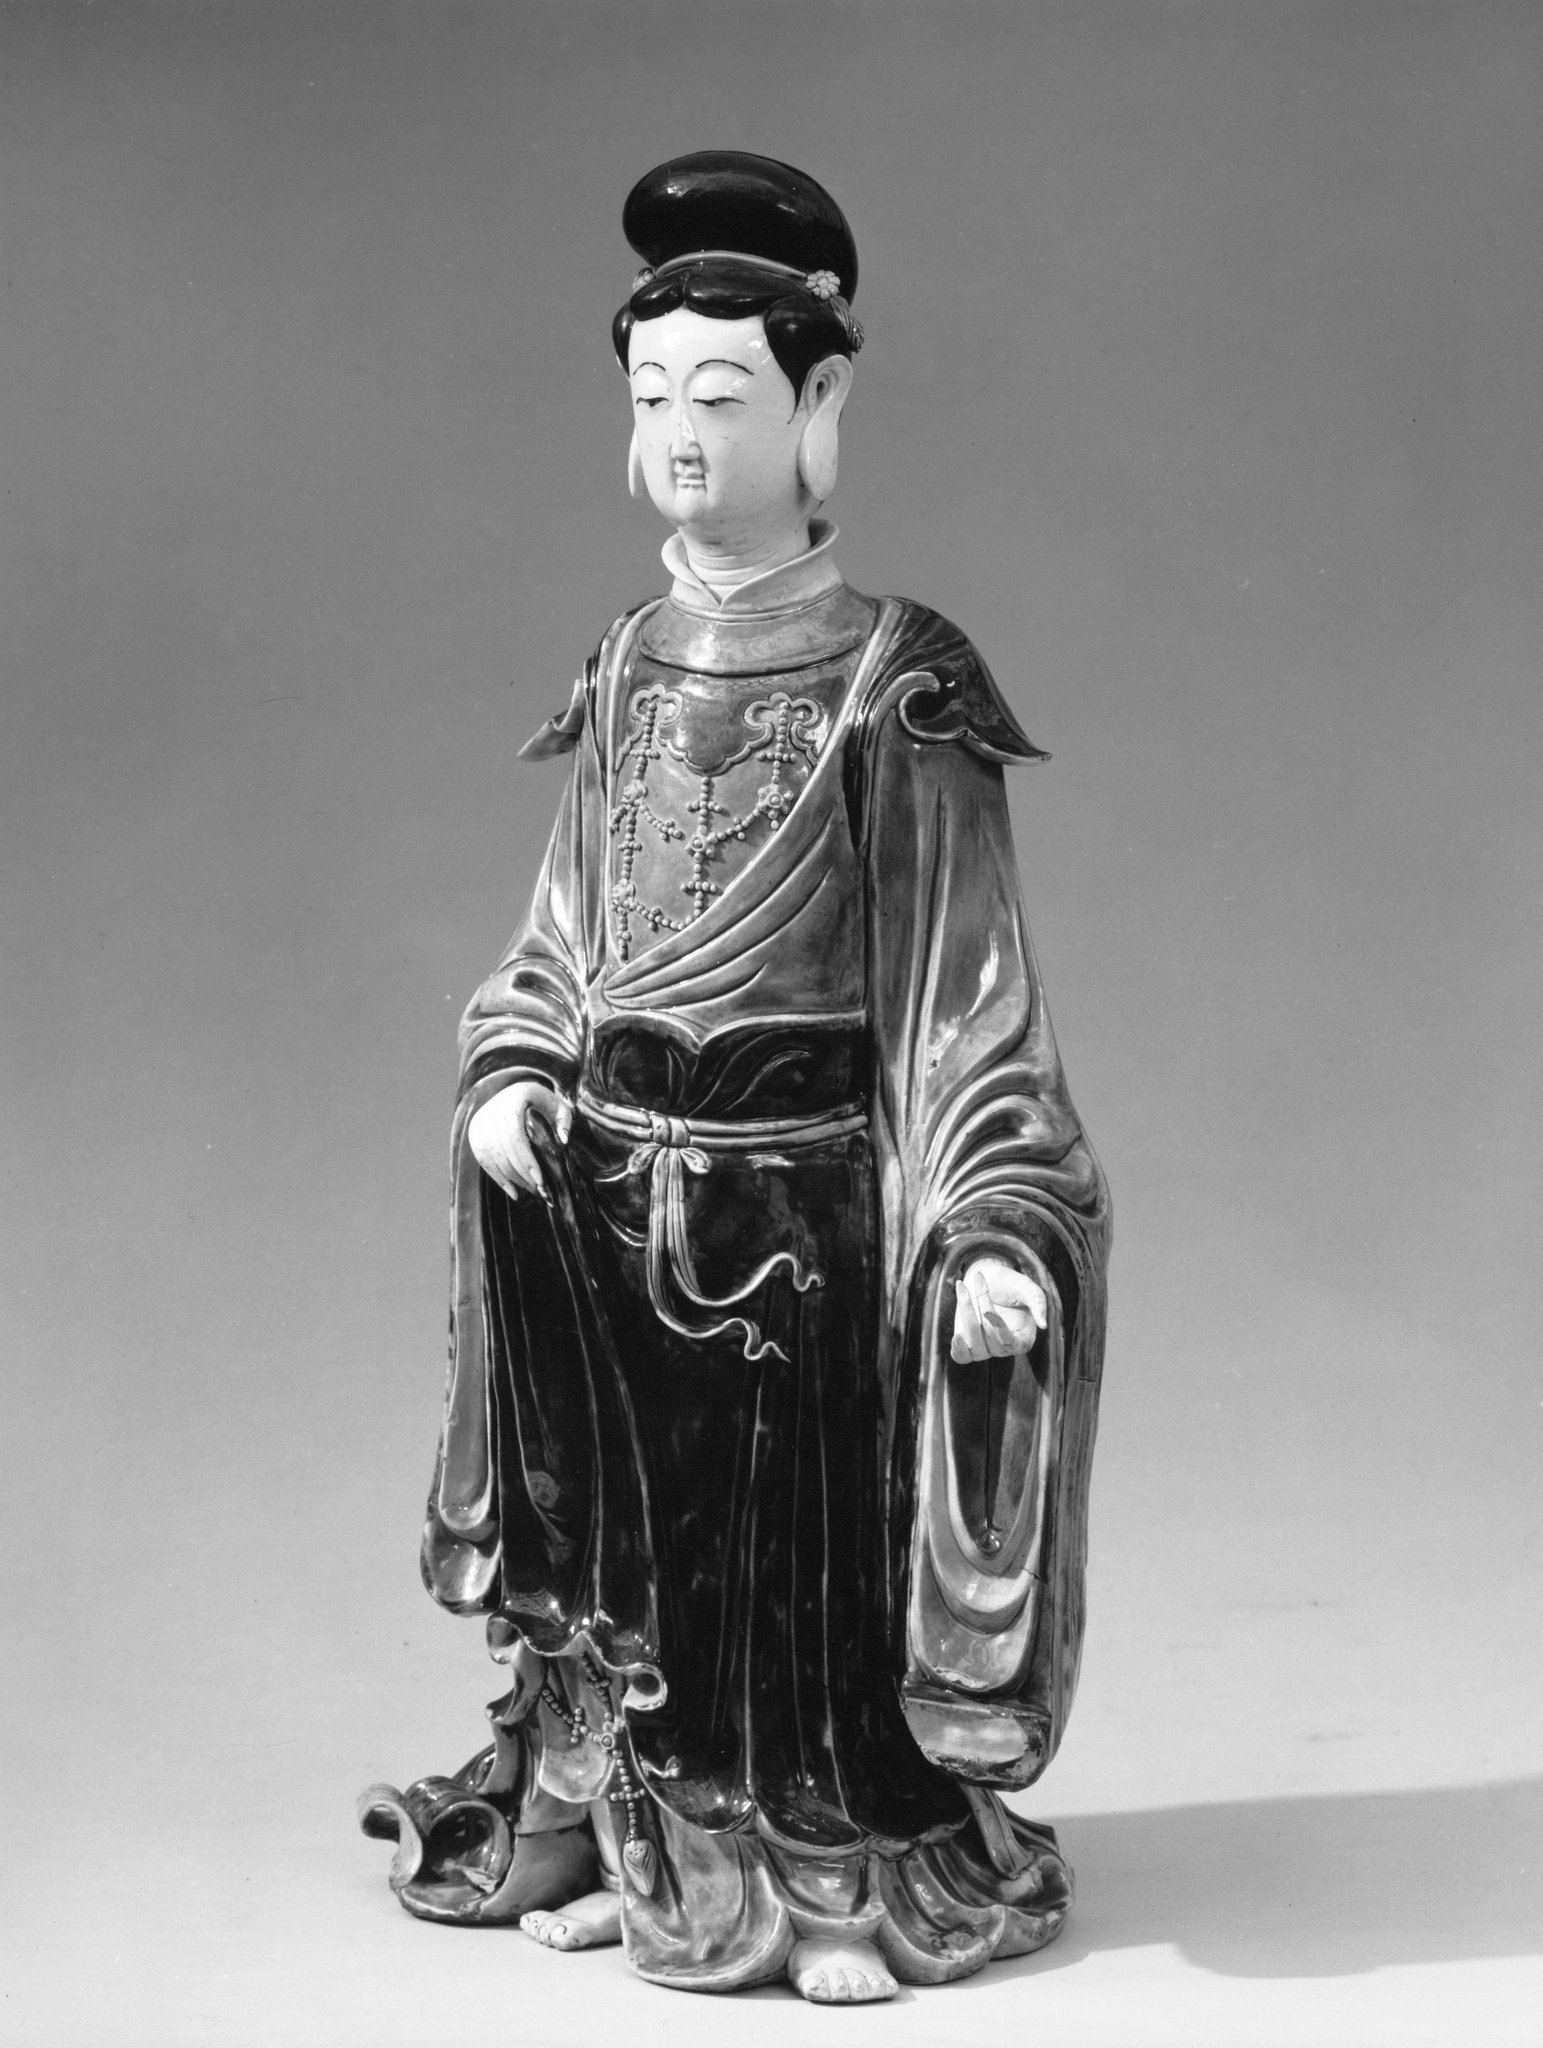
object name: figure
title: Figure of Guanyin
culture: chinese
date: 1368-1644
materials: porcelain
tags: buddhism,bodhisattvas